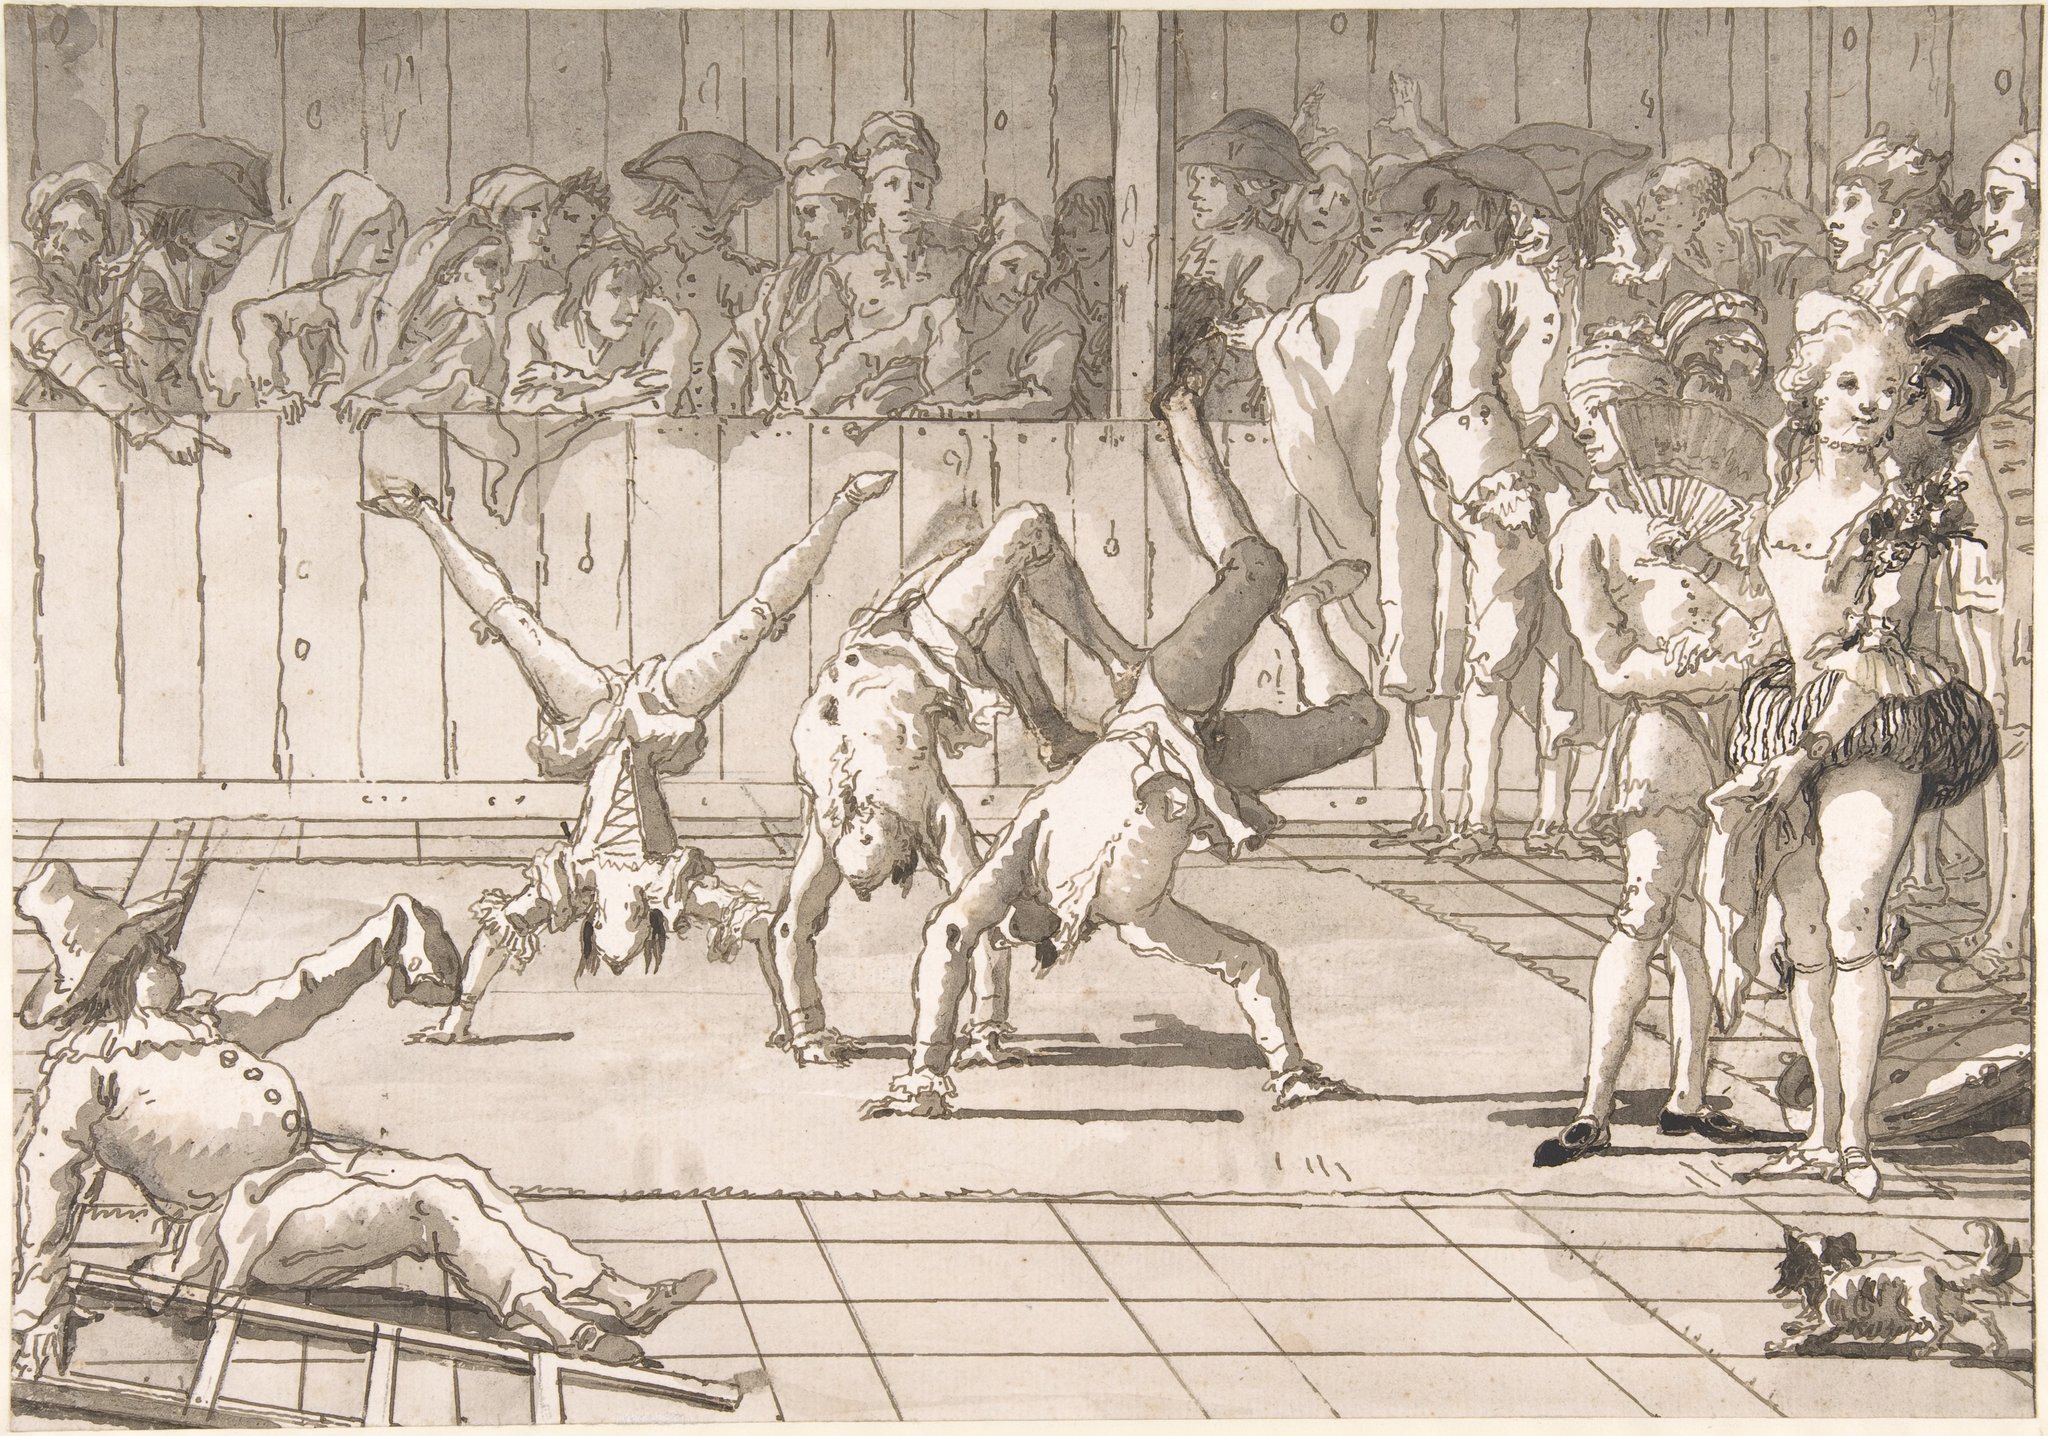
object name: drawing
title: Scene of Contemporary Life: The Acrobats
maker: giovanni domenico tiepolo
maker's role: artist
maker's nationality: italian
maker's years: 1727-1804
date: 1727-1804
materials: chalk, ink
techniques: brush, pen, wash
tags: men,women,spectators,acrobats